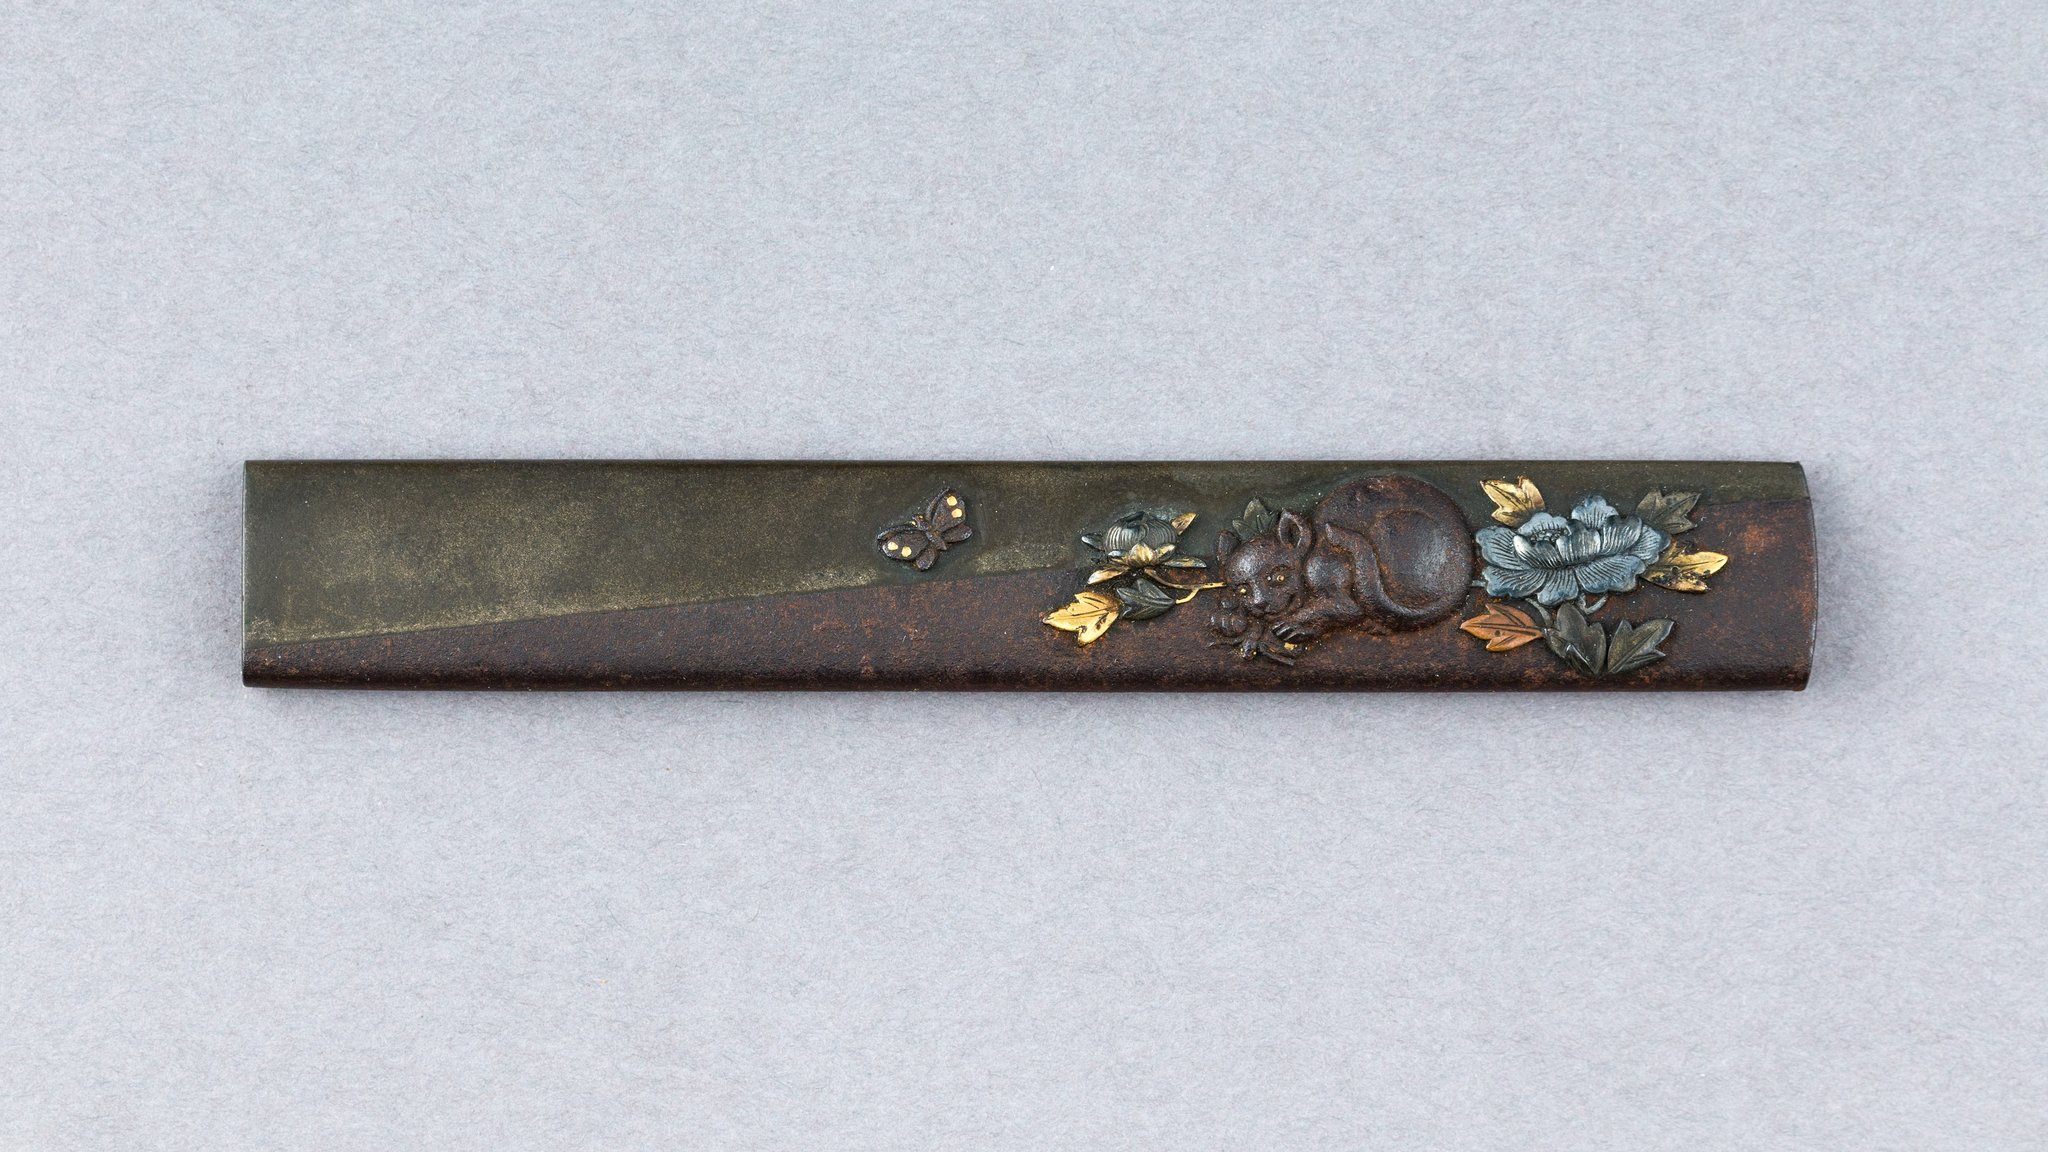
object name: knife handle kozuka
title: Knife Handle (Kozuka)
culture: japanese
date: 1615-1868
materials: copper, gold, iron, silver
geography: japan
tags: cats,butterflies,flowers